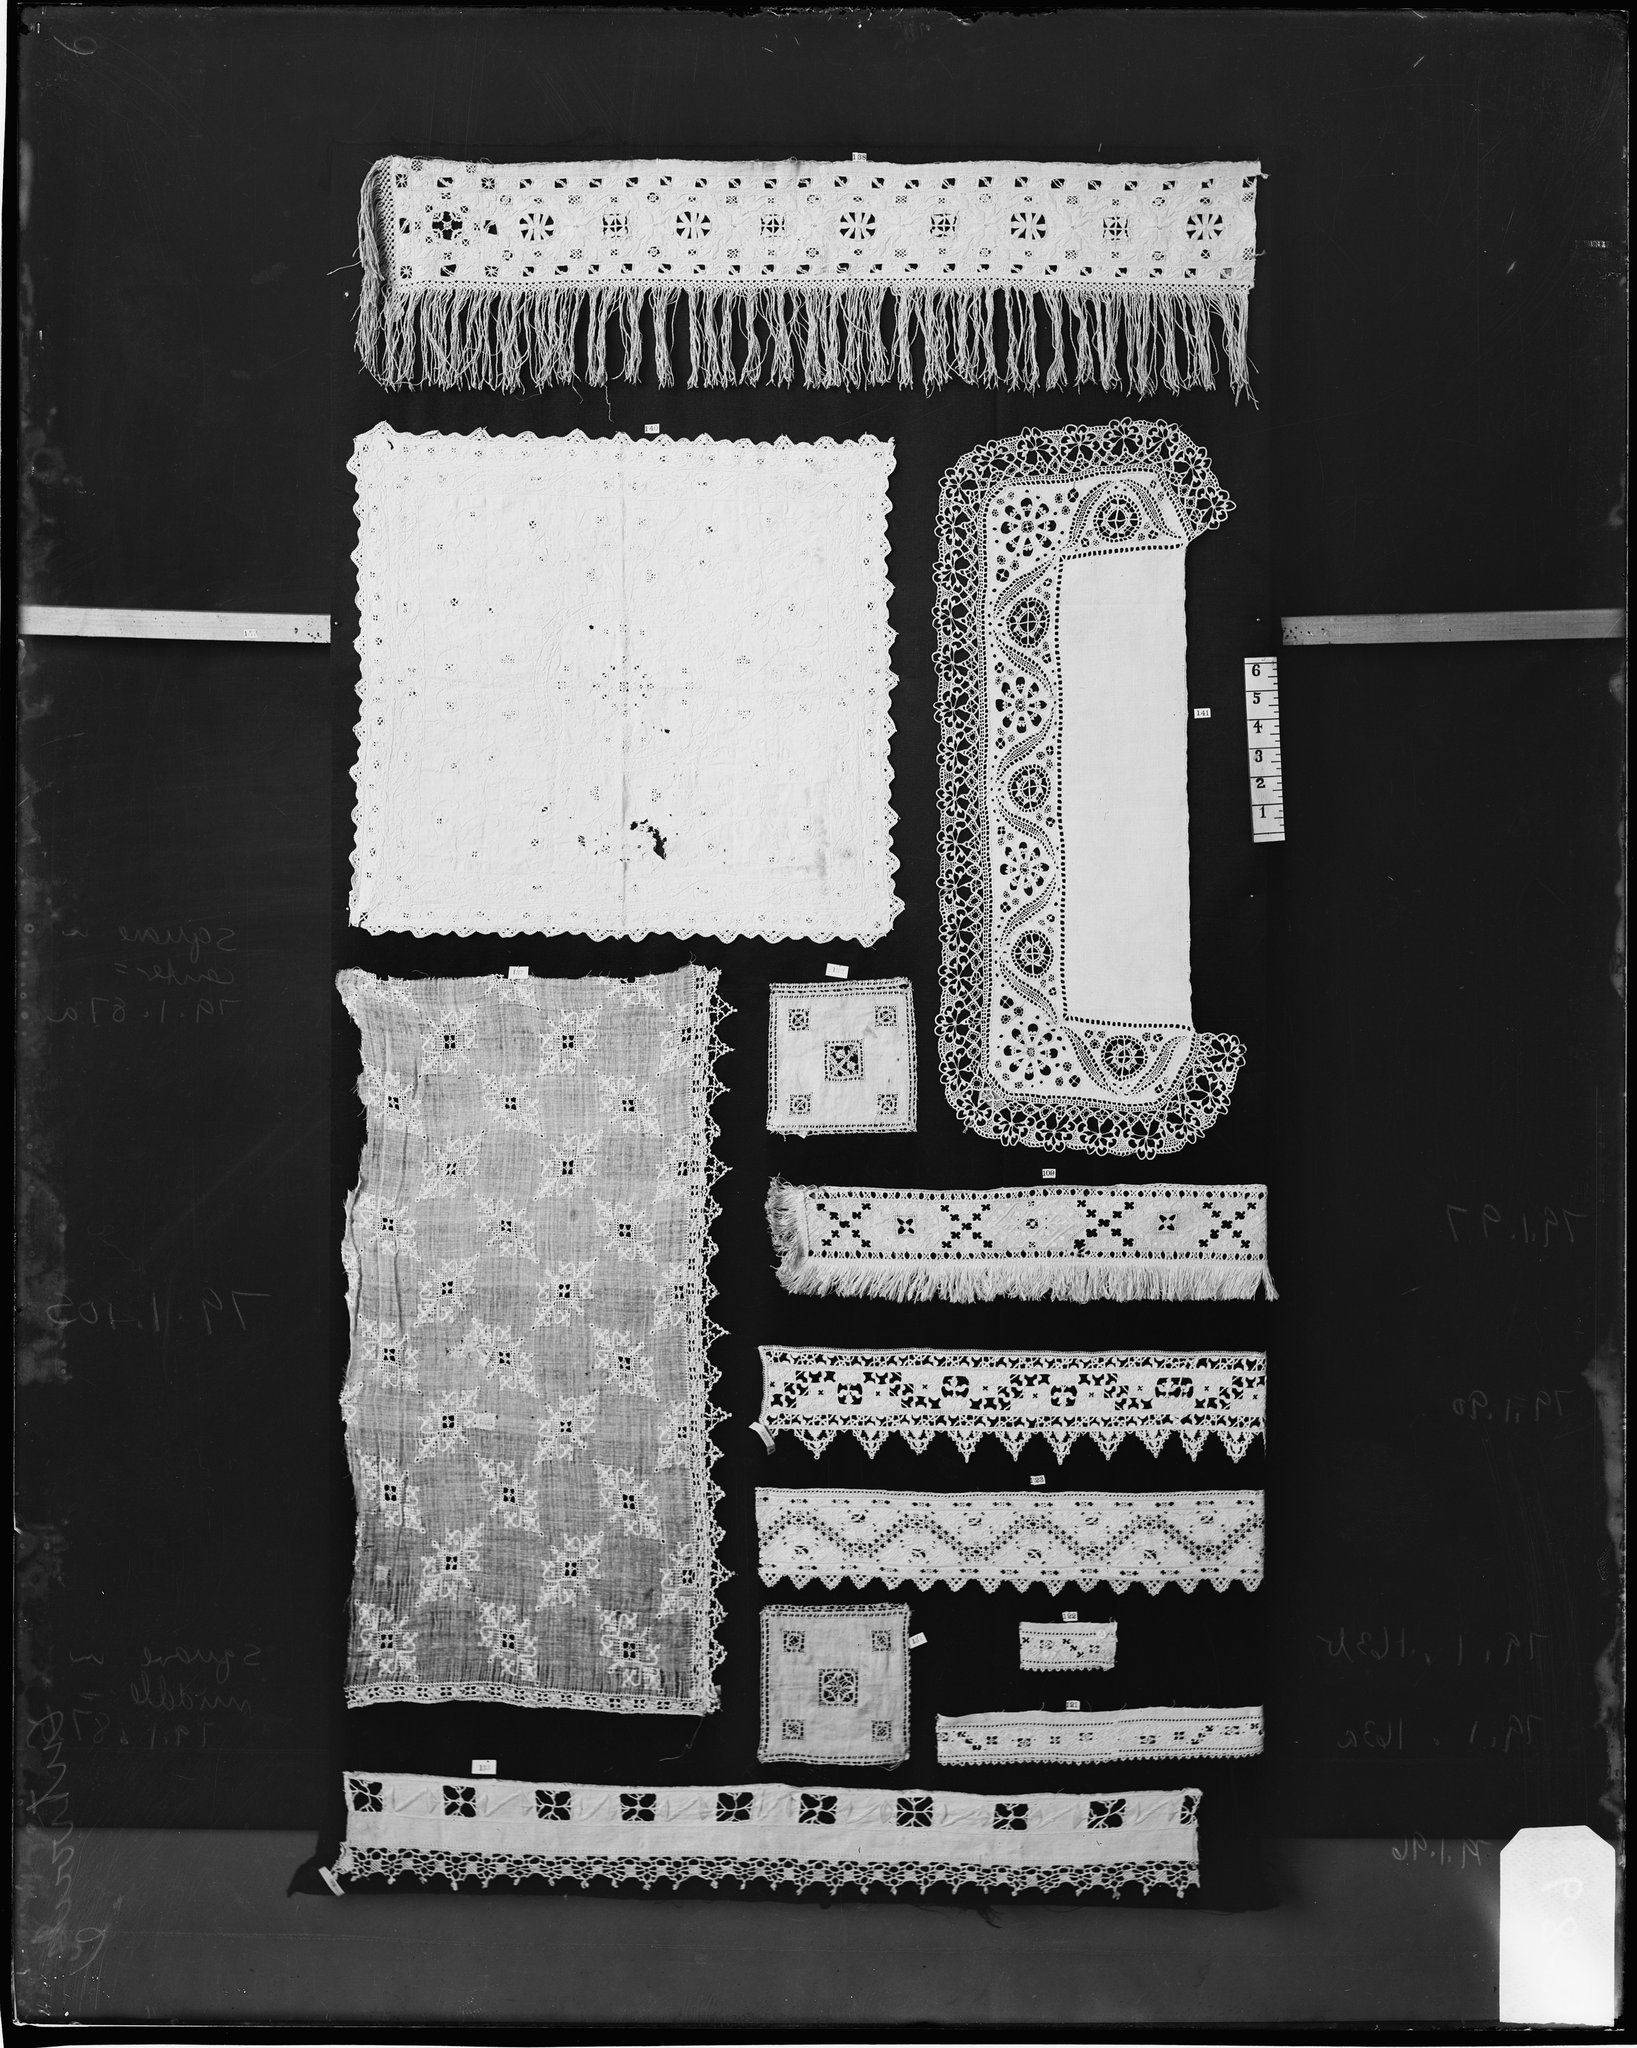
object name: band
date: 1501-1600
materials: linen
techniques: embroidery